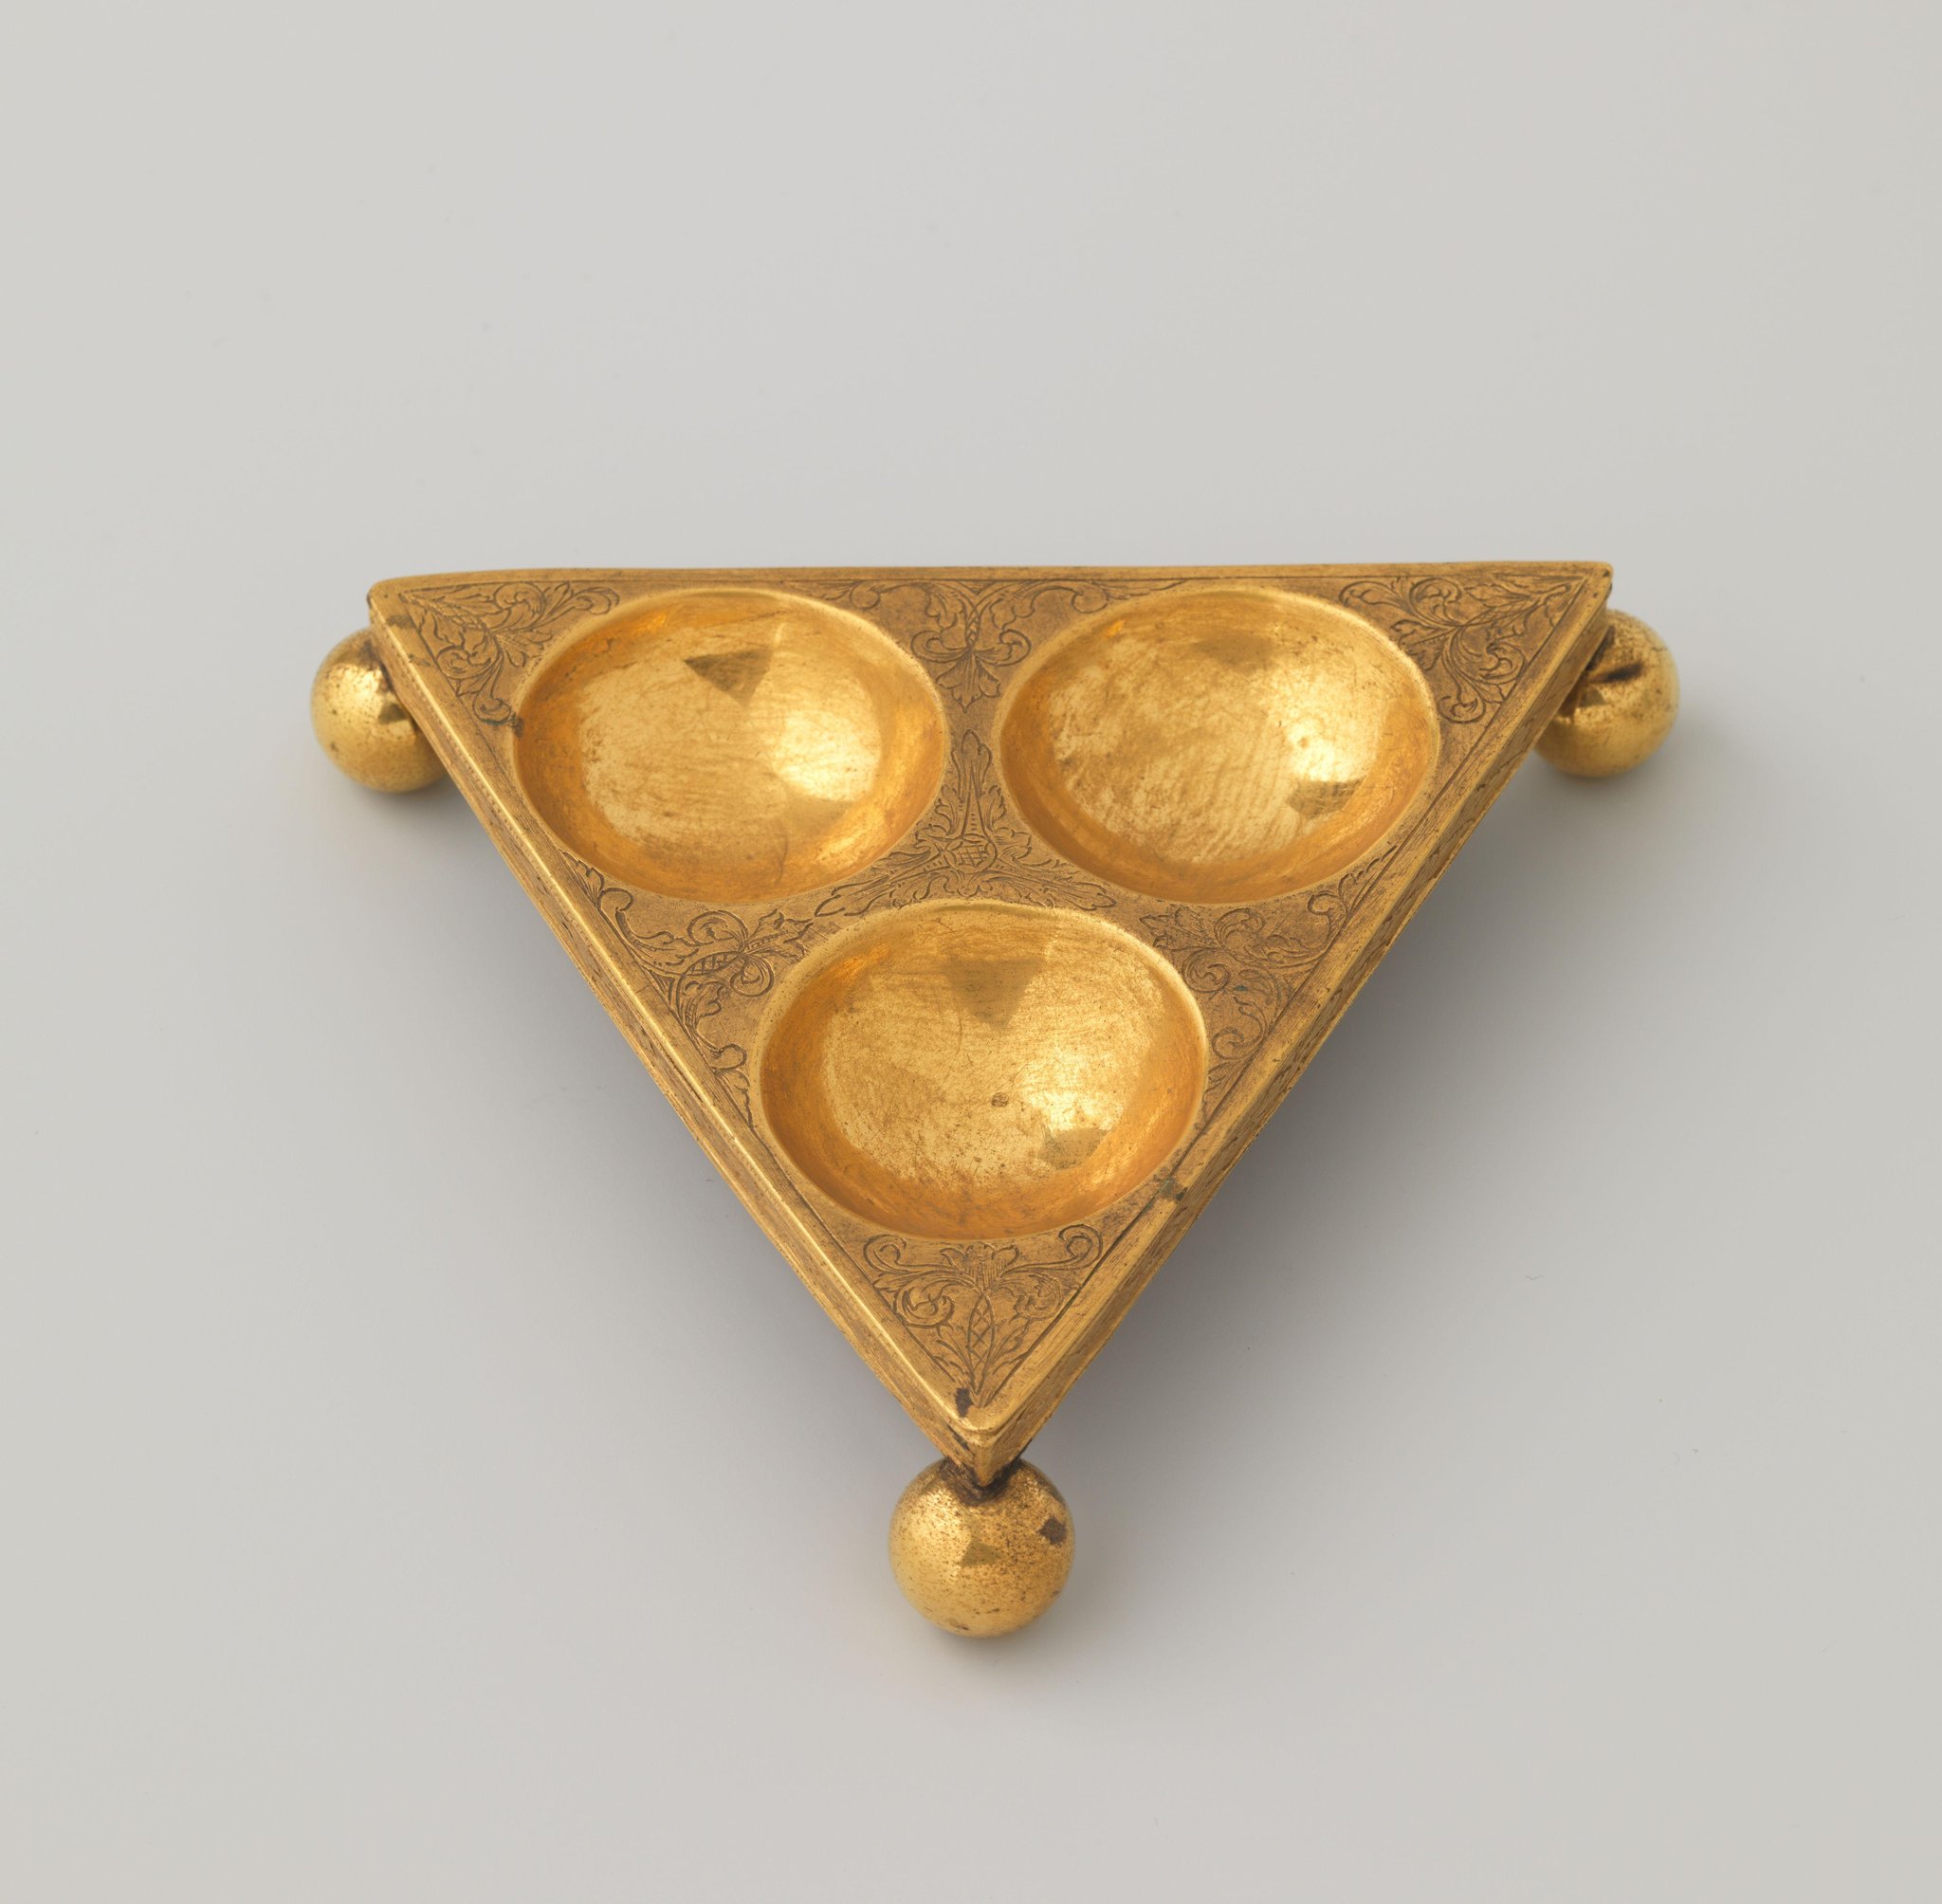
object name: salt condiment vessel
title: Galvanoplastische reproductie van een driehoekig zoutvat op bolpoten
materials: copper, silver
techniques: gilding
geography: london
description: Galvanoplastische reproductie van een driehoekig zoutvat op bolpoten met drie ronde verdieping; aan iedere zijde arabesken. Verguld.